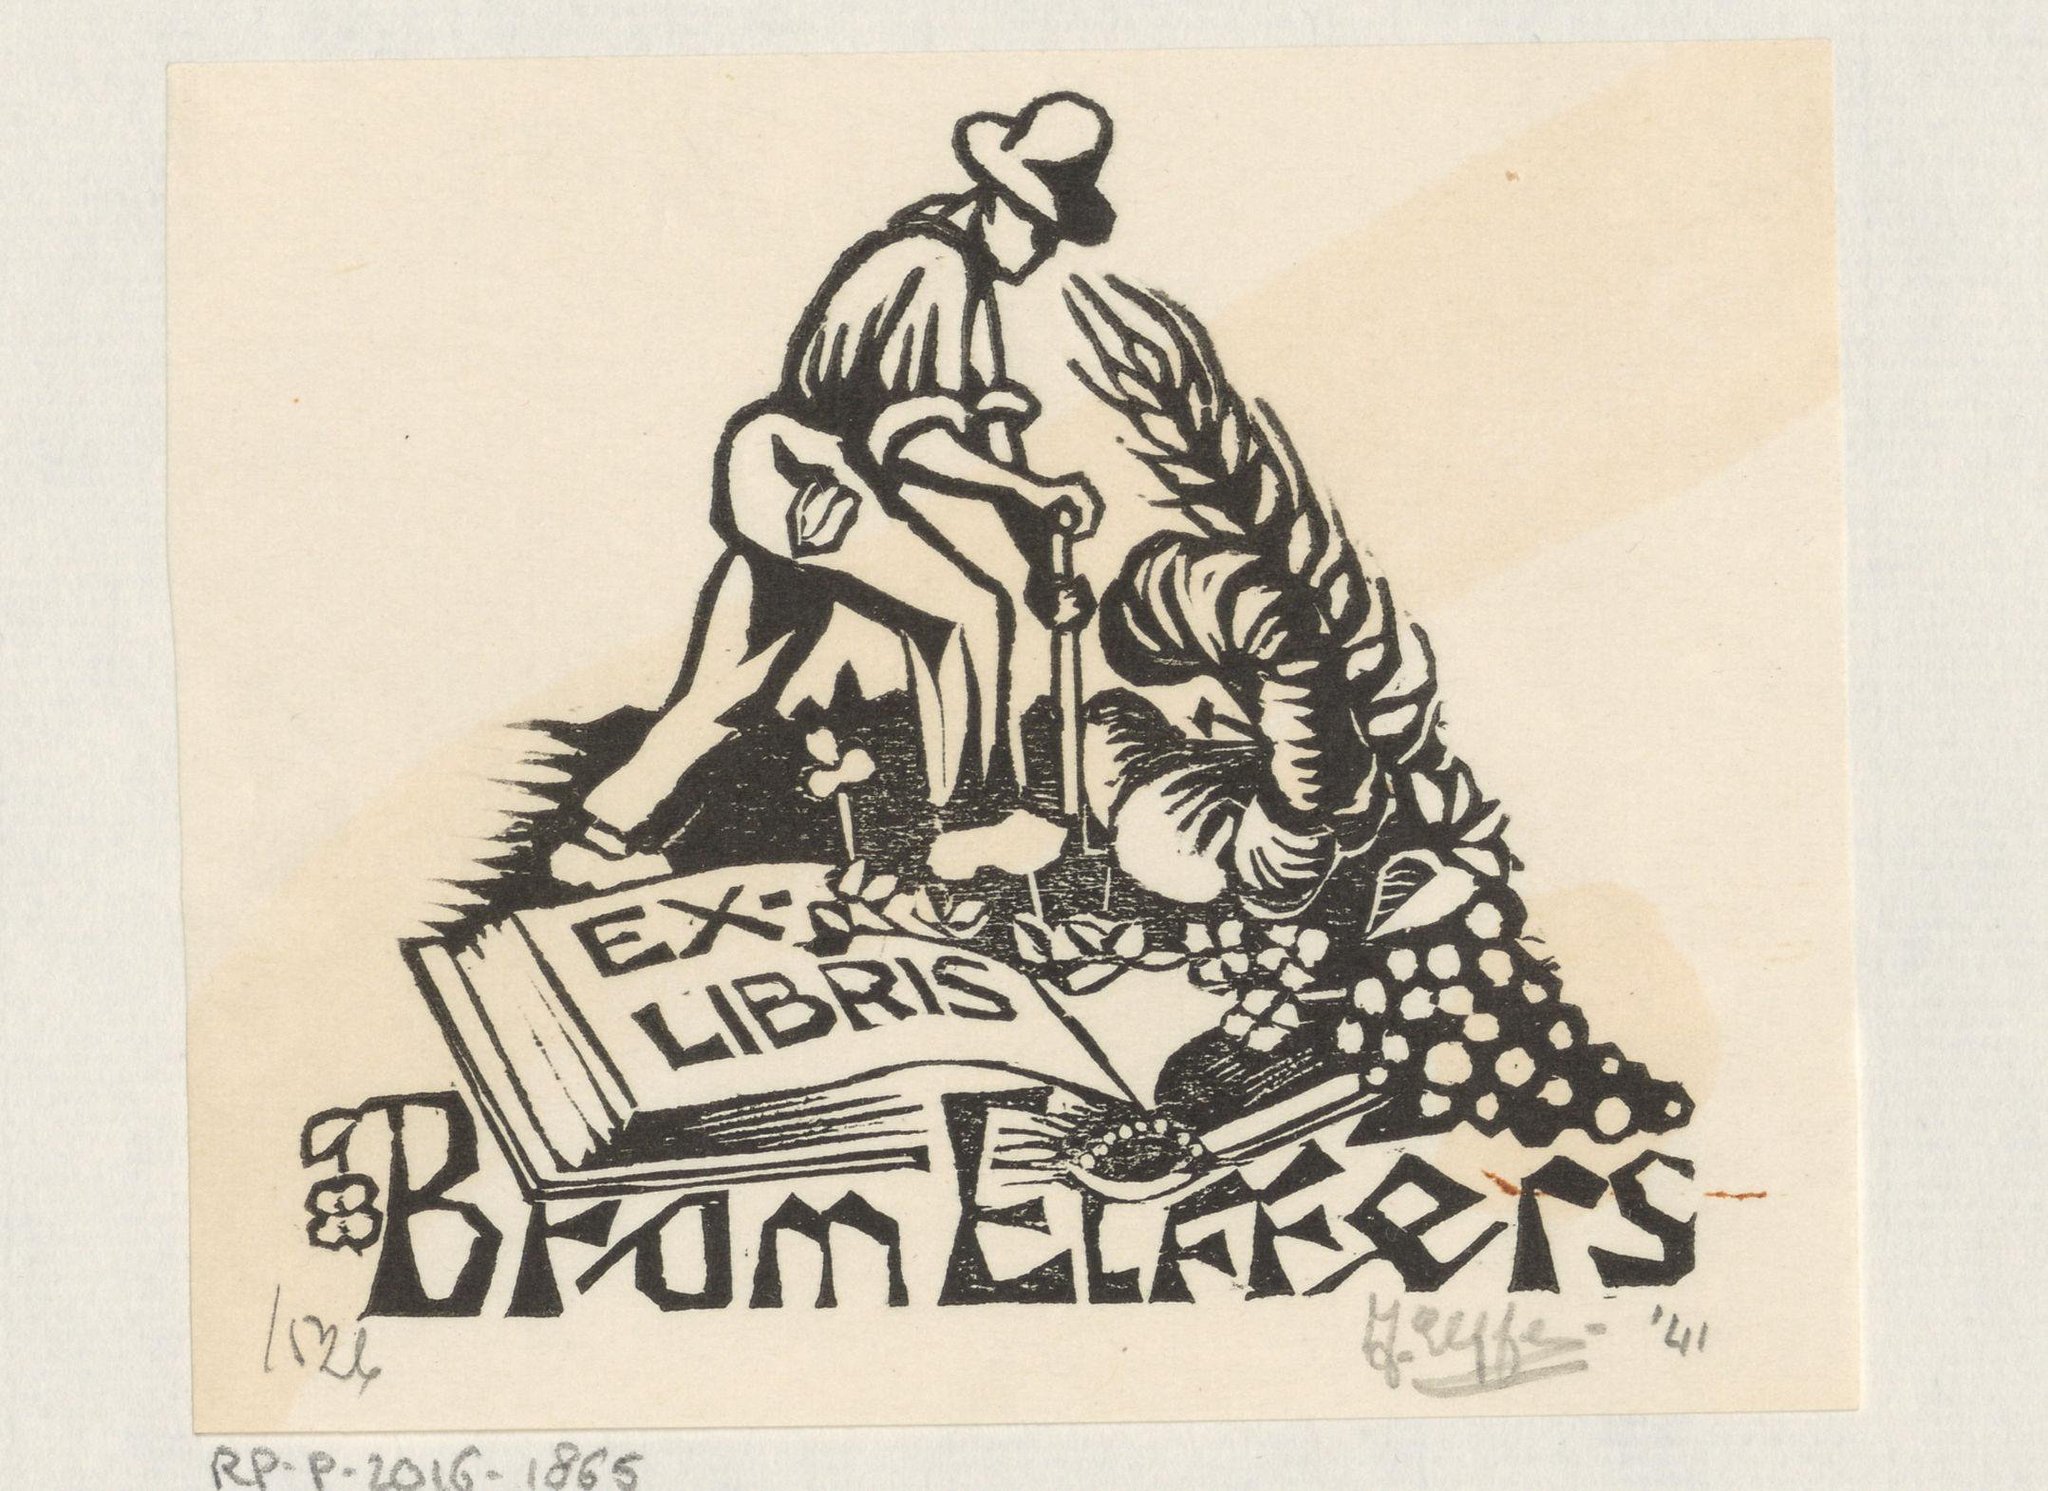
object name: bookplate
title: Ex libris van Bram Elffers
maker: jan elffers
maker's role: print maker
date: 1941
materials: paper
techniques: woodcut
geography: netherlands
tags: horticulture, vegetable culture, market gardening, digging (industrial process), gardening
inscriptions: signature, date and inscription: ‘[...] J. Elffers '41’